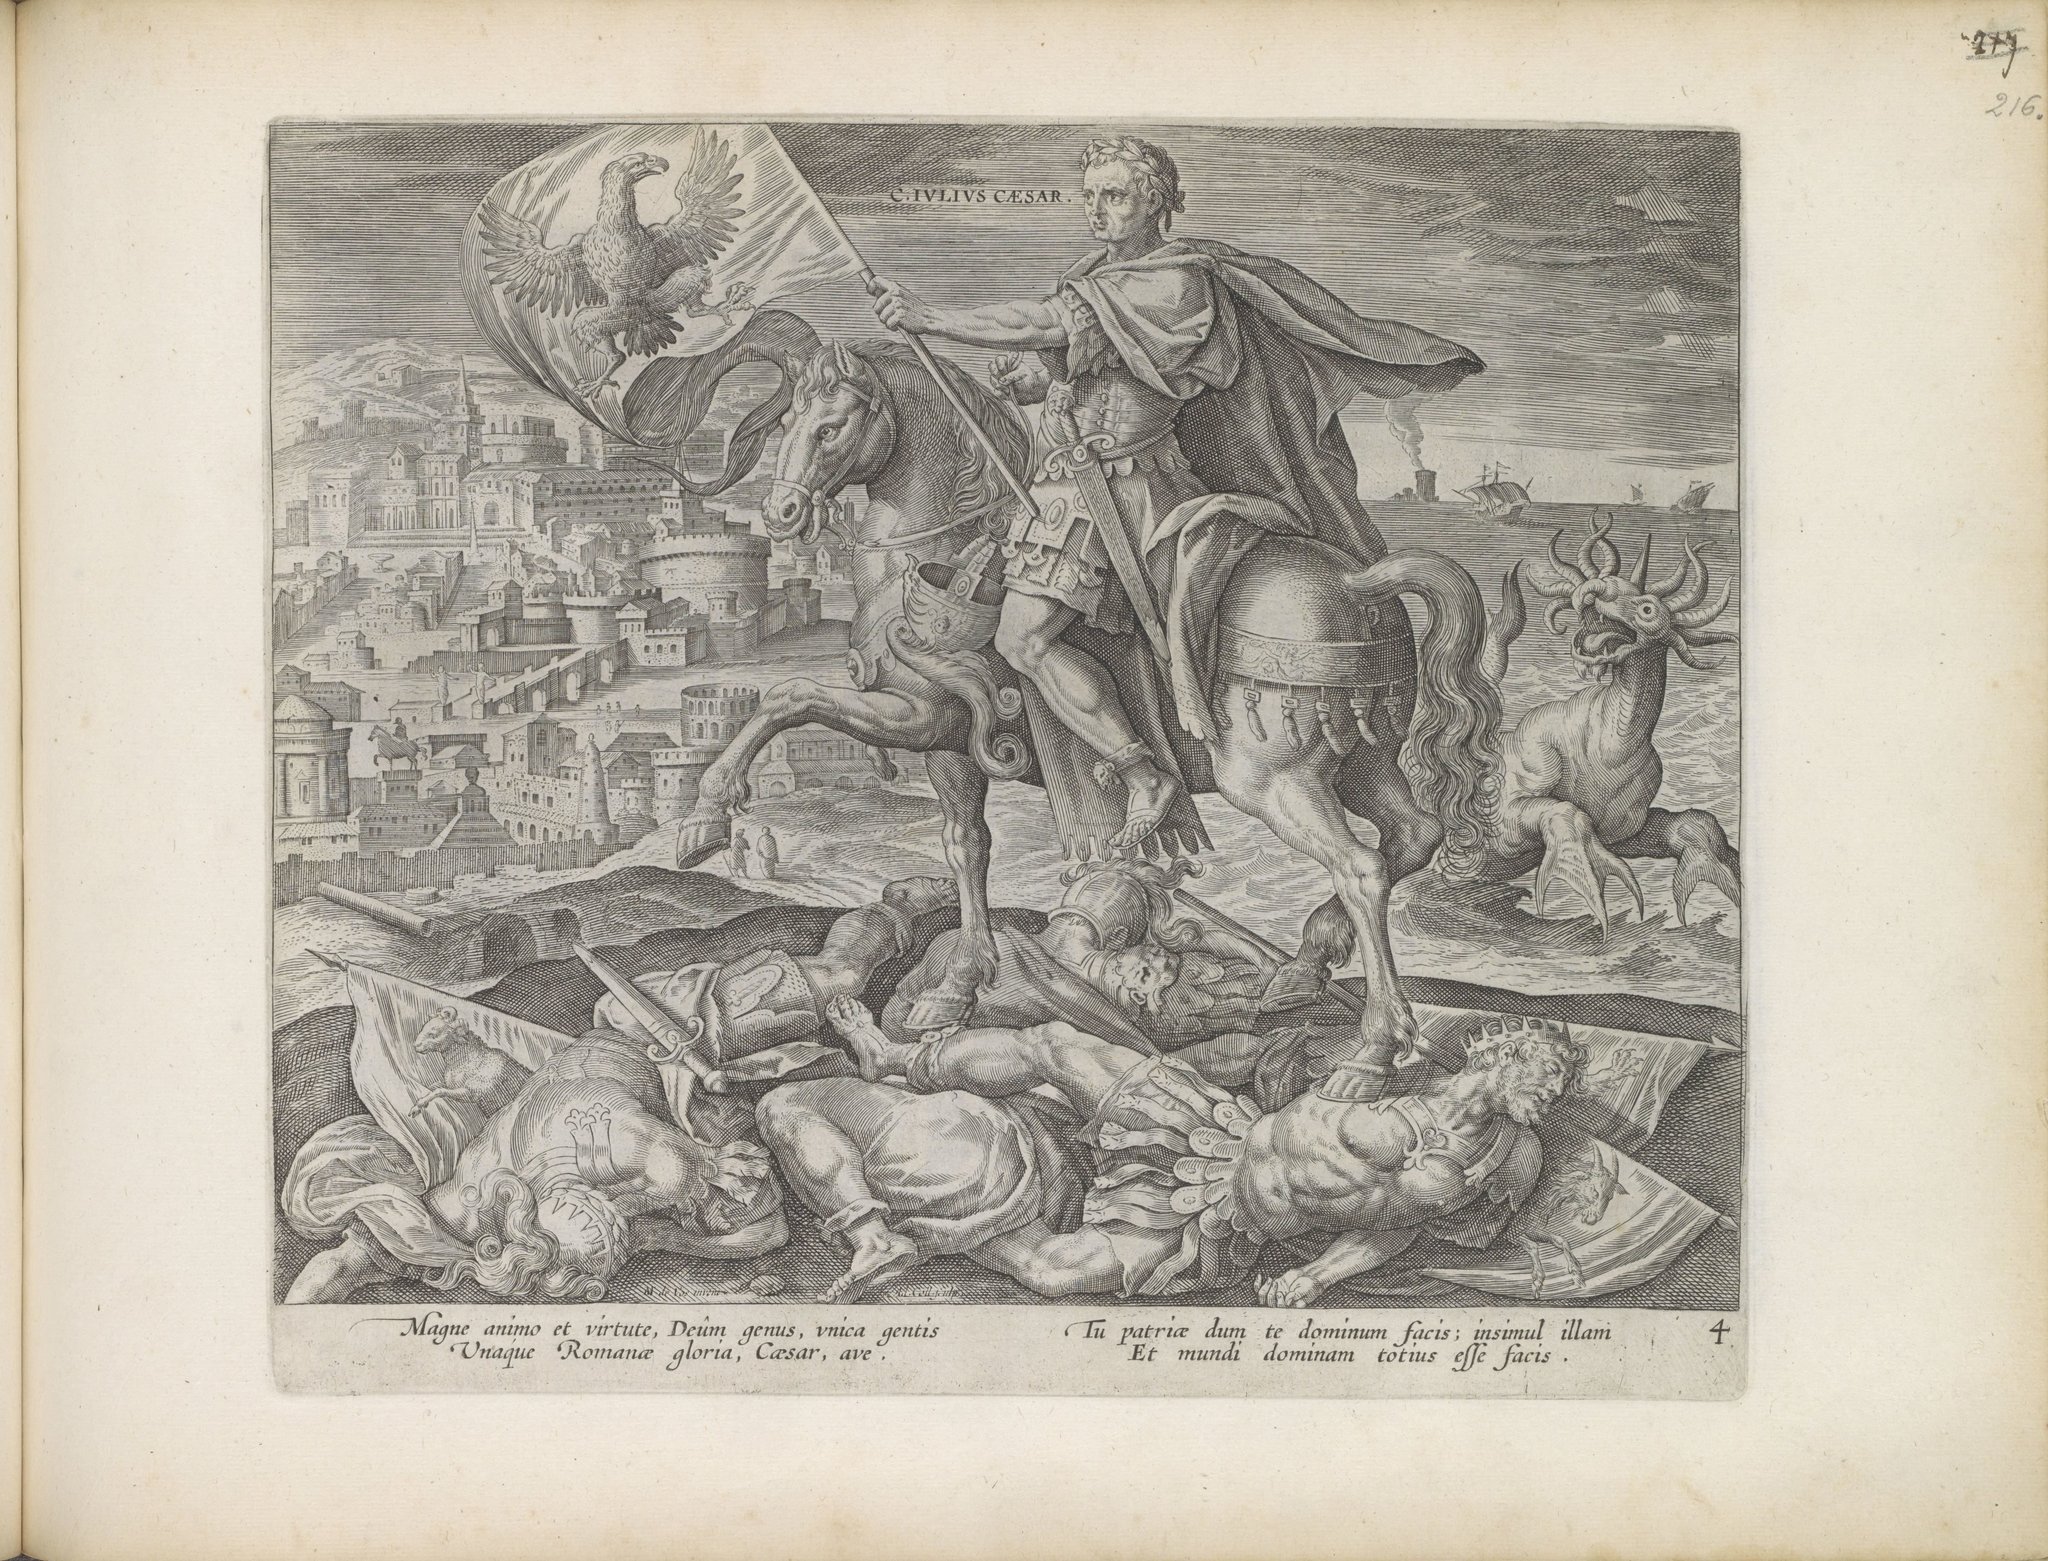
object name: album leaf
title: Theatrum Biblicum Hoc Est Historiae Sacrae Veteris et Novi Testamenti Tabulis Aeneis Expressae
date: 1570-1618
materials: paper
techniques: engraving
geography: amsterdam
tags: (story of) c. julius caesar, the world empires symbolized by four beasts (daniel ch. 7), the great devouring monster with many horns (one of them with eyes on it) ~ daniel's visions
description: Julius Caesar rijdt op een paard, in zijn hand een vlag met de afbeelding van een adelaar (Rome). Het paard vertrapt koning Cyrus van Perzië, Ninus van Babylonië en Alexander de Grote. Op de achtergrond een stadsgezicht. Naast Julius Caesar komt uit de zee een veelhoornig monster tevoorschijn, een verwijzing naar een visioen van Daniël over de opkomst van vier koninkrijken in de wereld. Onder de voorstelling een verwijzing in het Latijn naar de Bijbeltekst in Dan. 7. Deze prent maakt deel uit van een album.